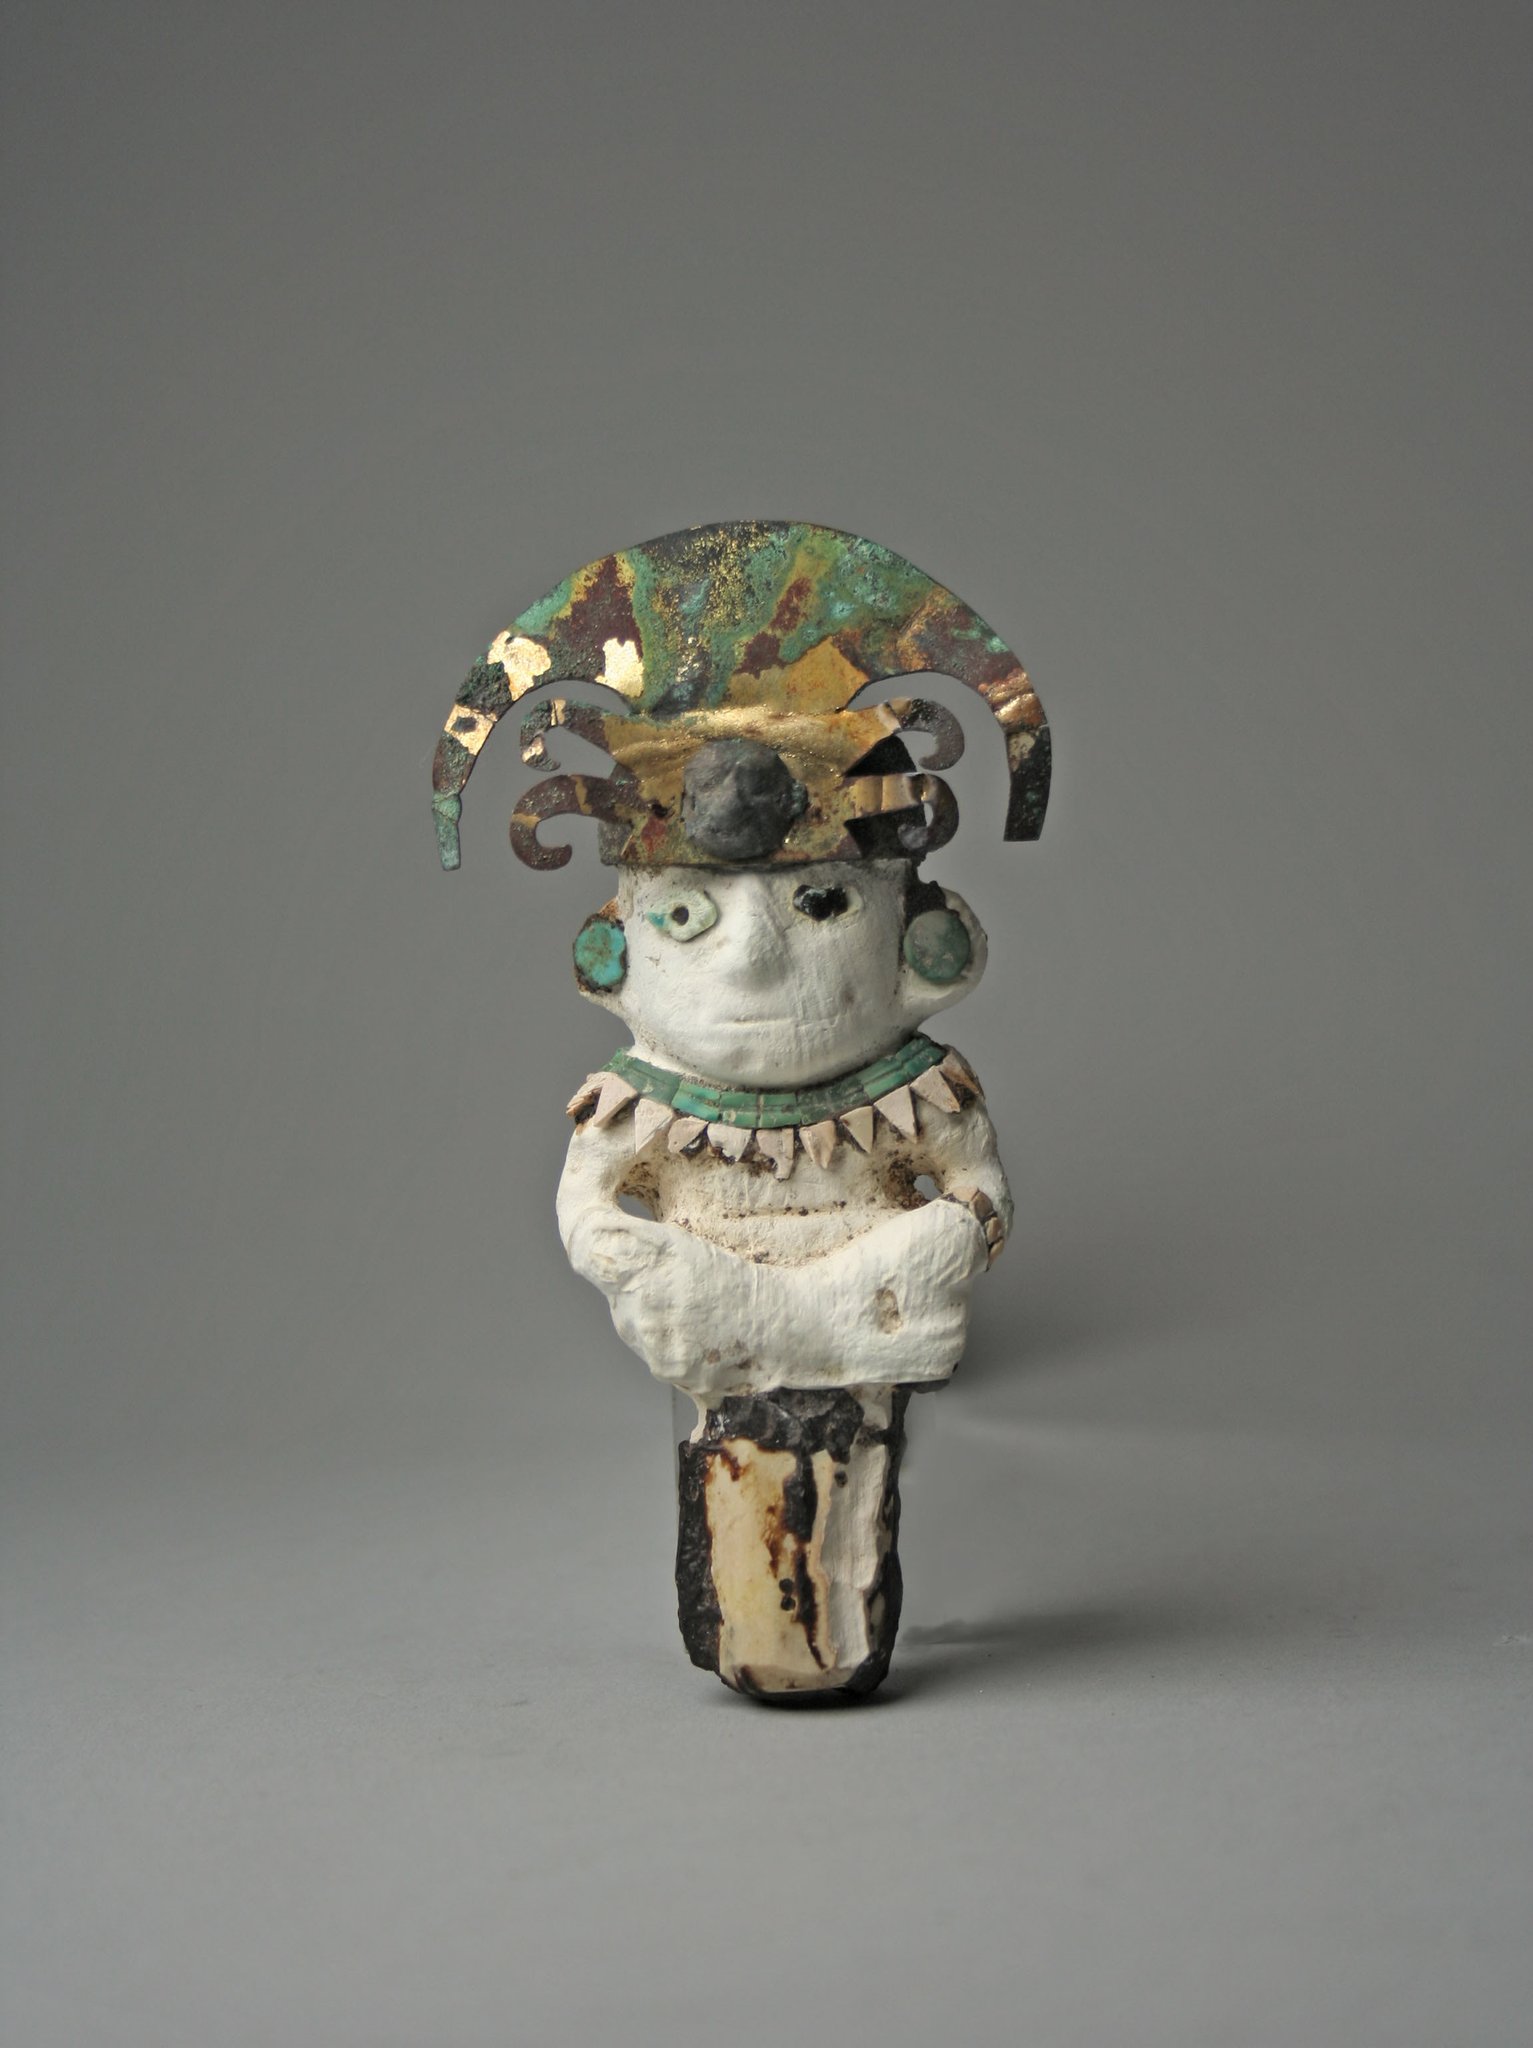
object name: ornament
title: Chalk Figure Ornament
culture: moche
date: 501-700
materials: chalk, gilt copper, metal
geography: peru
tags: human figures